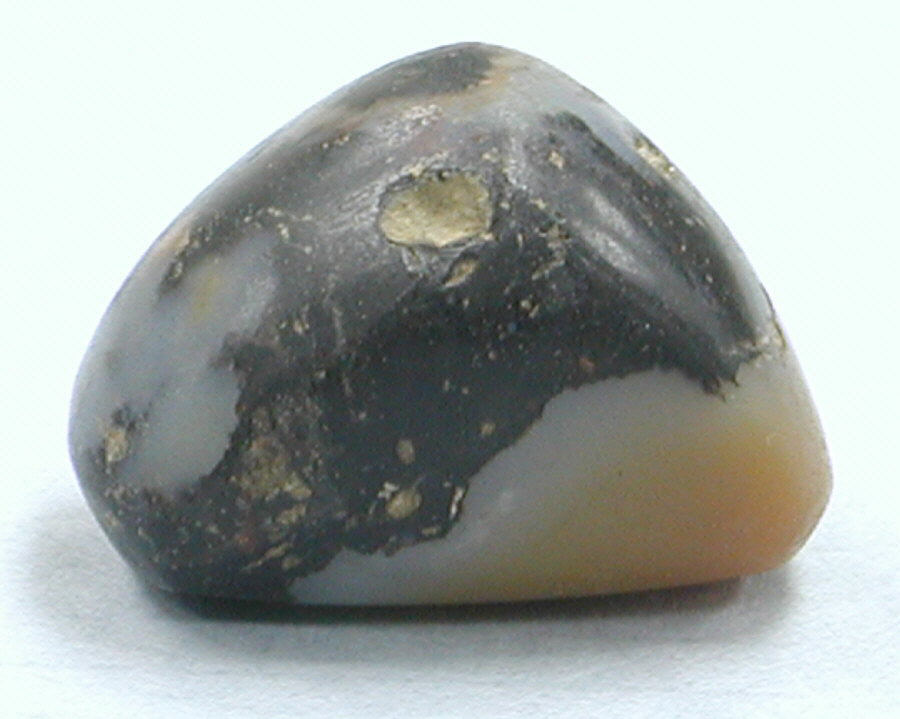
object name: ritual stone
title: Stone Pulidor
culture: mexican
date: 1501-1600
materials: stone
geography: mexico